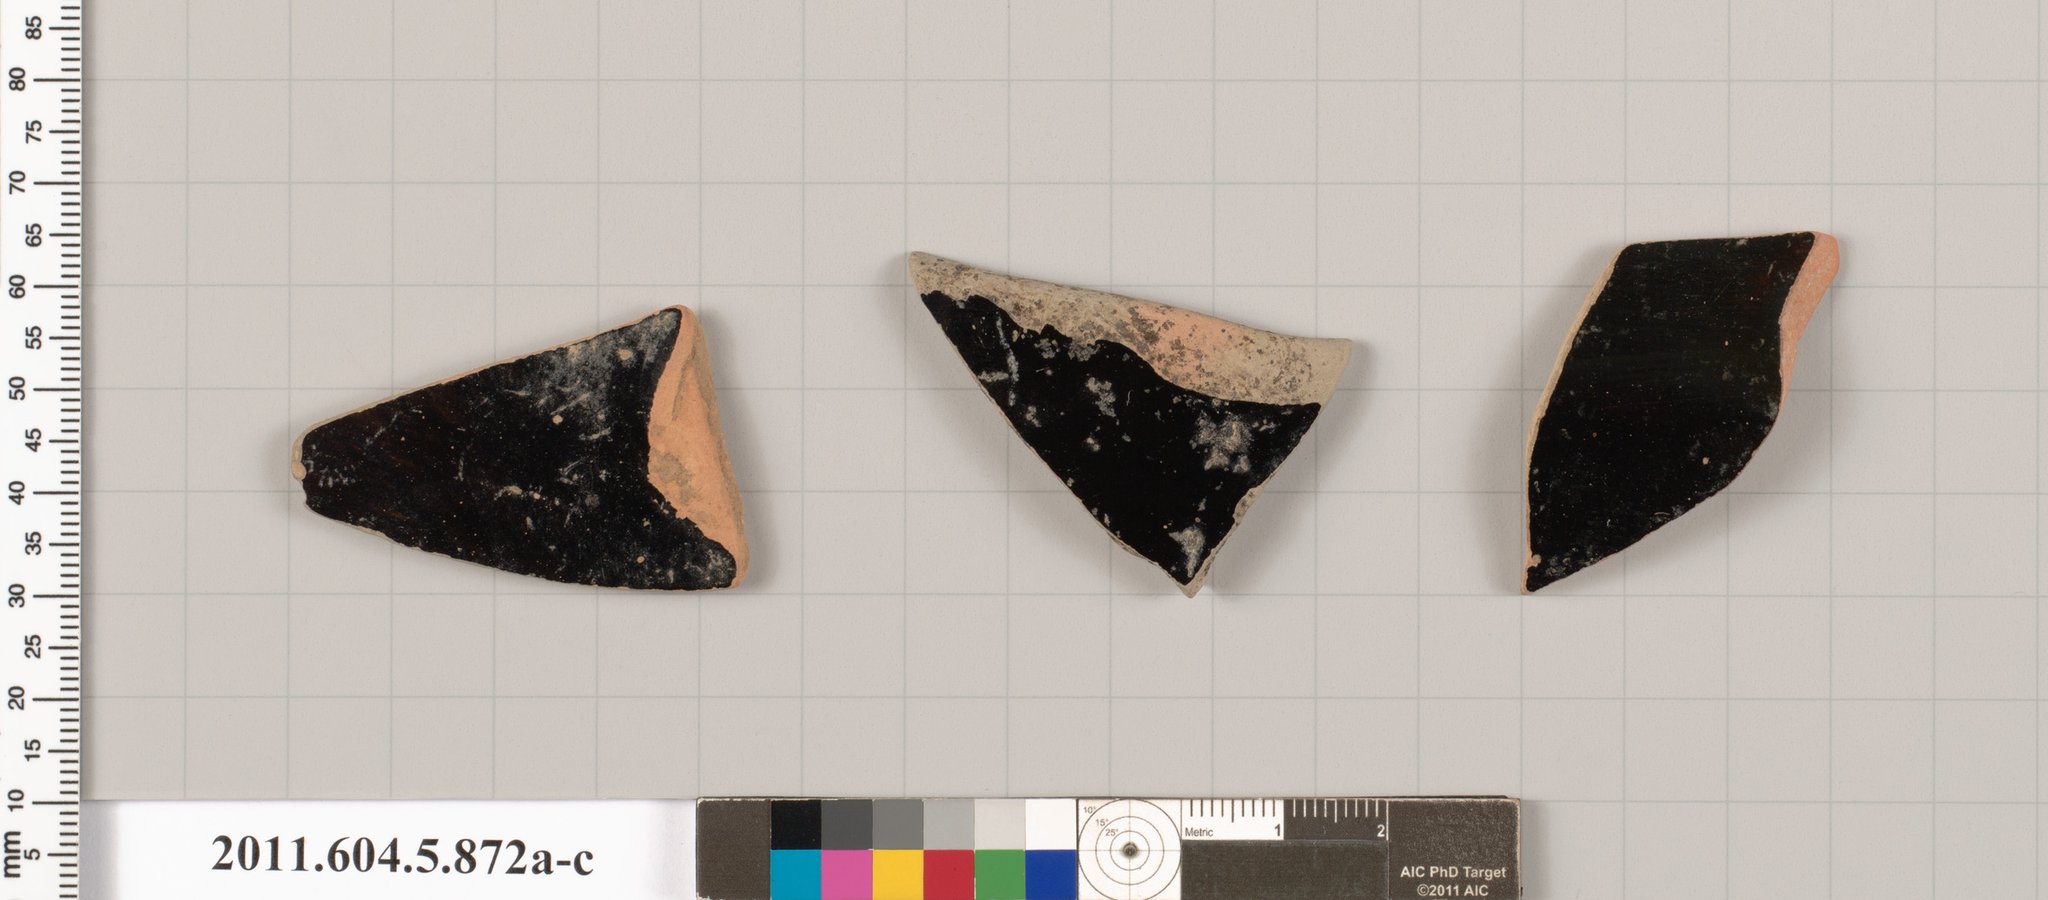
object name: kylix fragment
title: Terracotta fragments of kylikes (drinking cups)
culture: greek, attic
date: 600-401 BCE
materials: terracotta